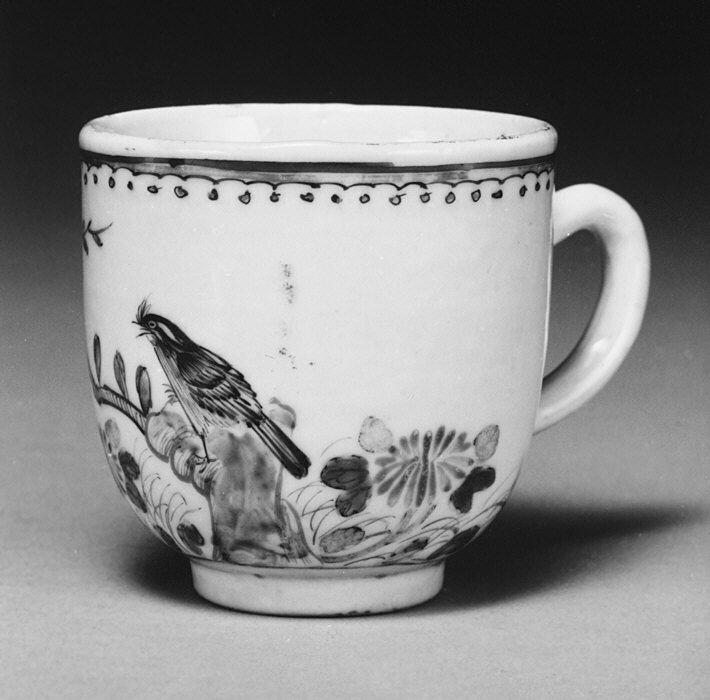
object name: cup and saucer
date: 1760-1770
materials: hard paste porcelain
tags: birds,flowers